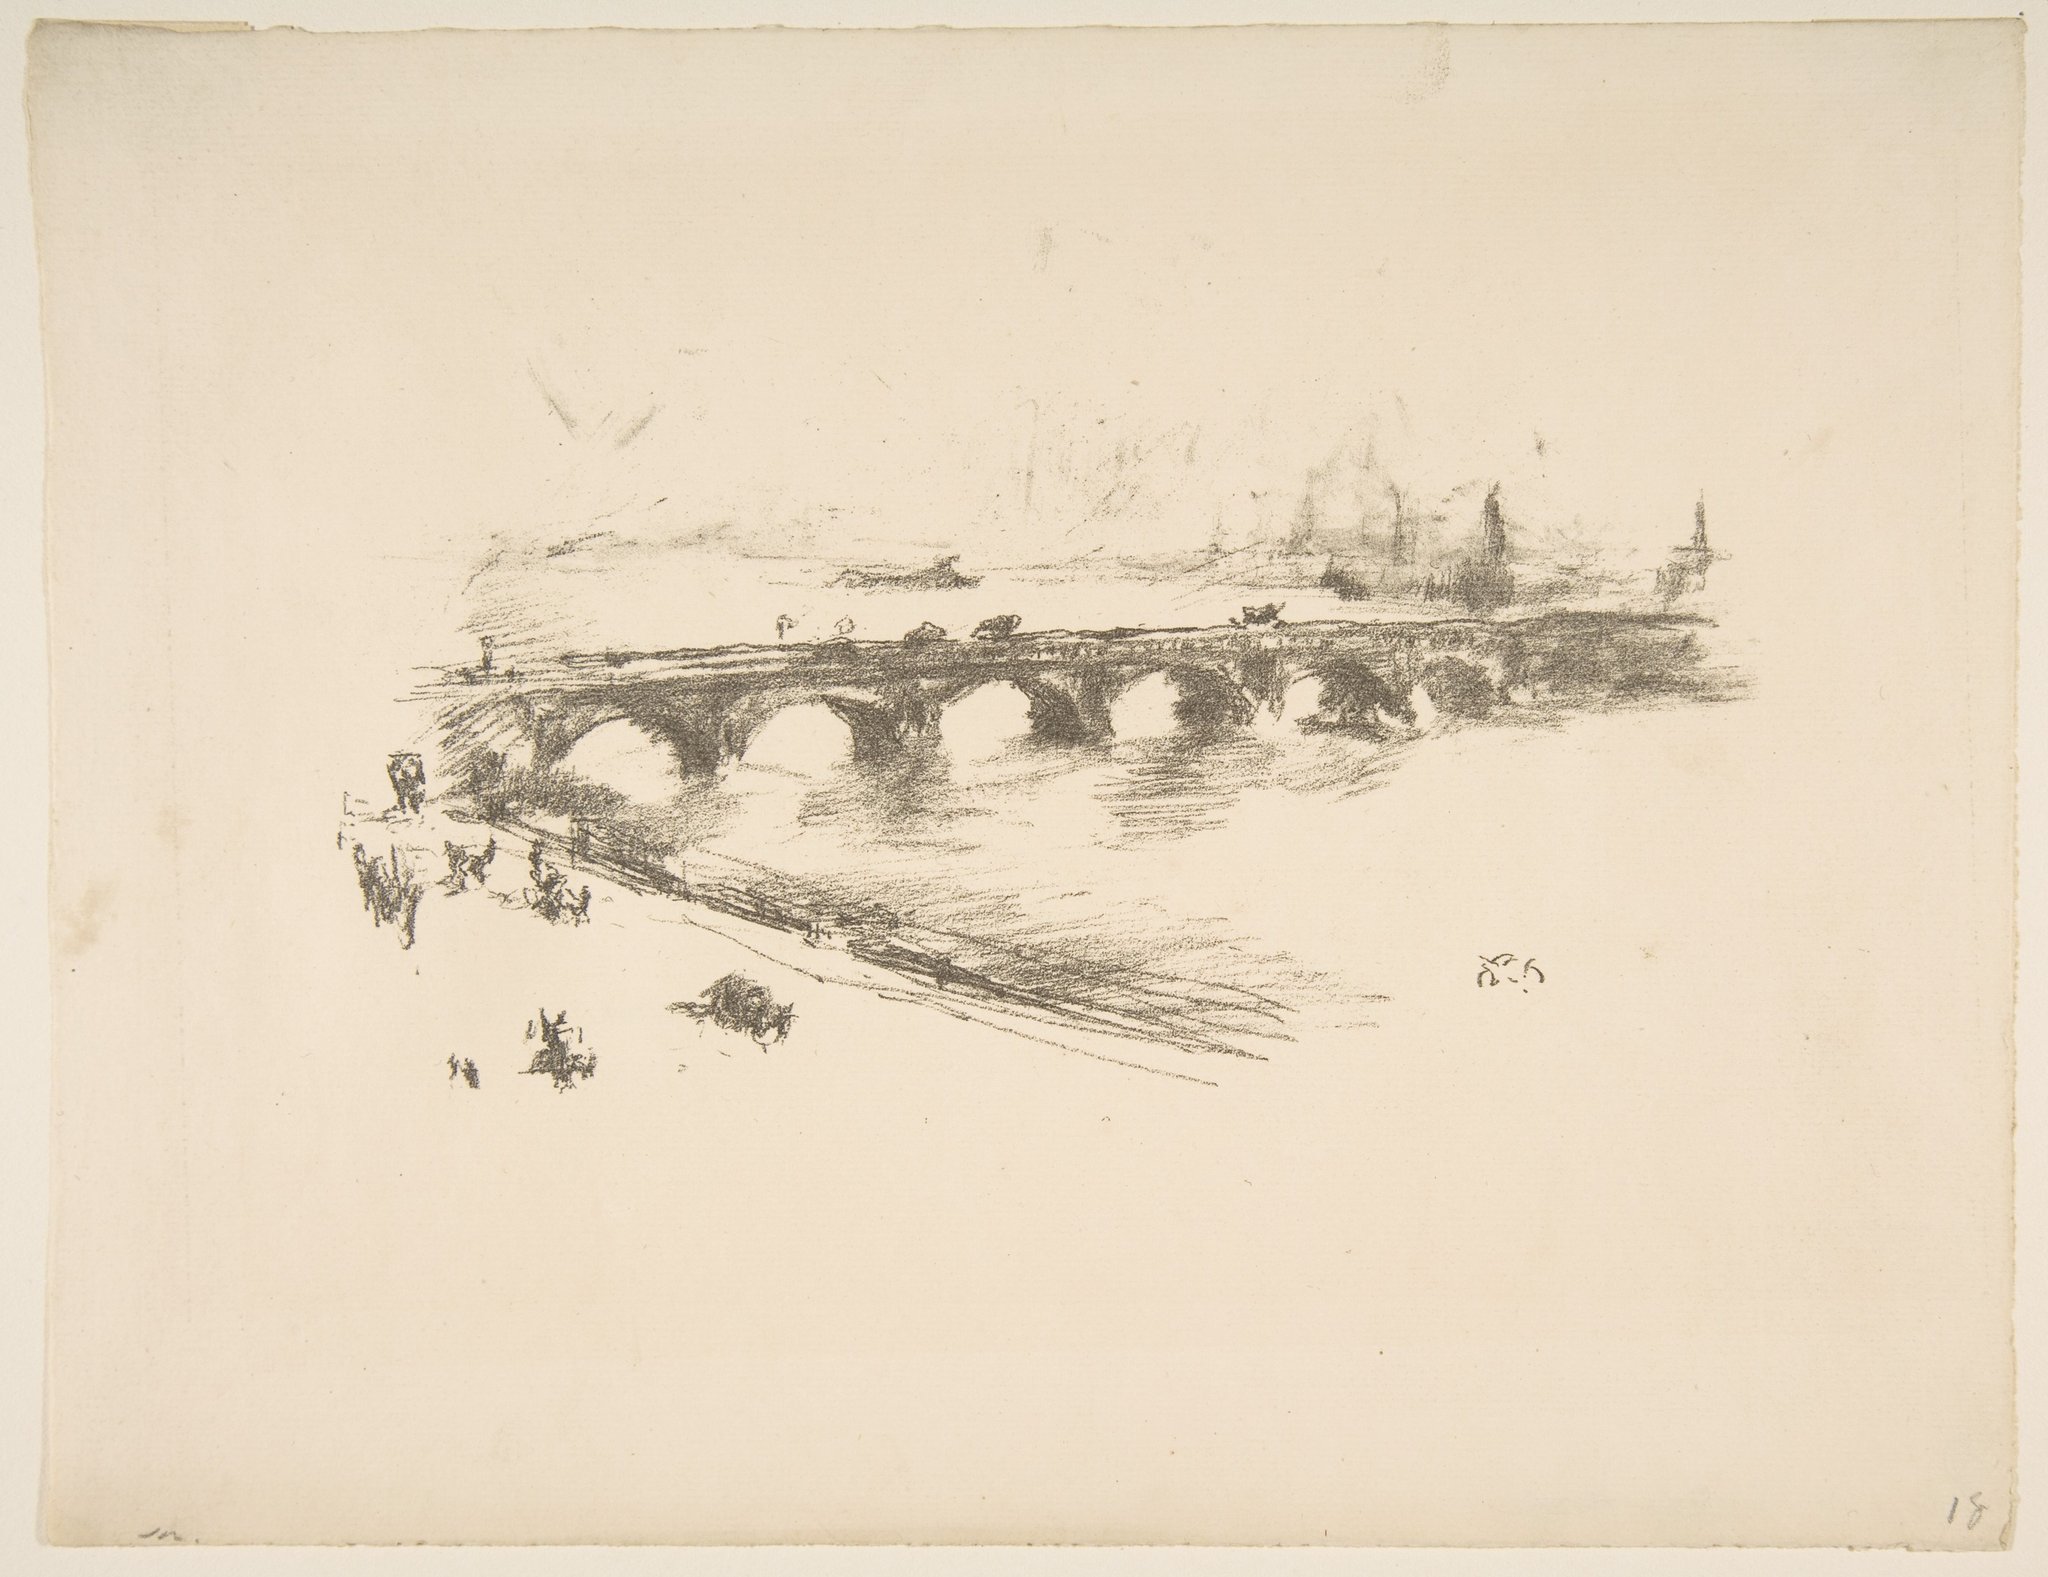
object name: print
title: Evening, Little Waterloo Bridge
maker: james mcneill whistler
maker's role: artist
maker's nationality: american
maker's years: 1834-1903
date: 1896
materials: ink, paper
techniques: printing, stumping, lithography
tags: bridges,rivers